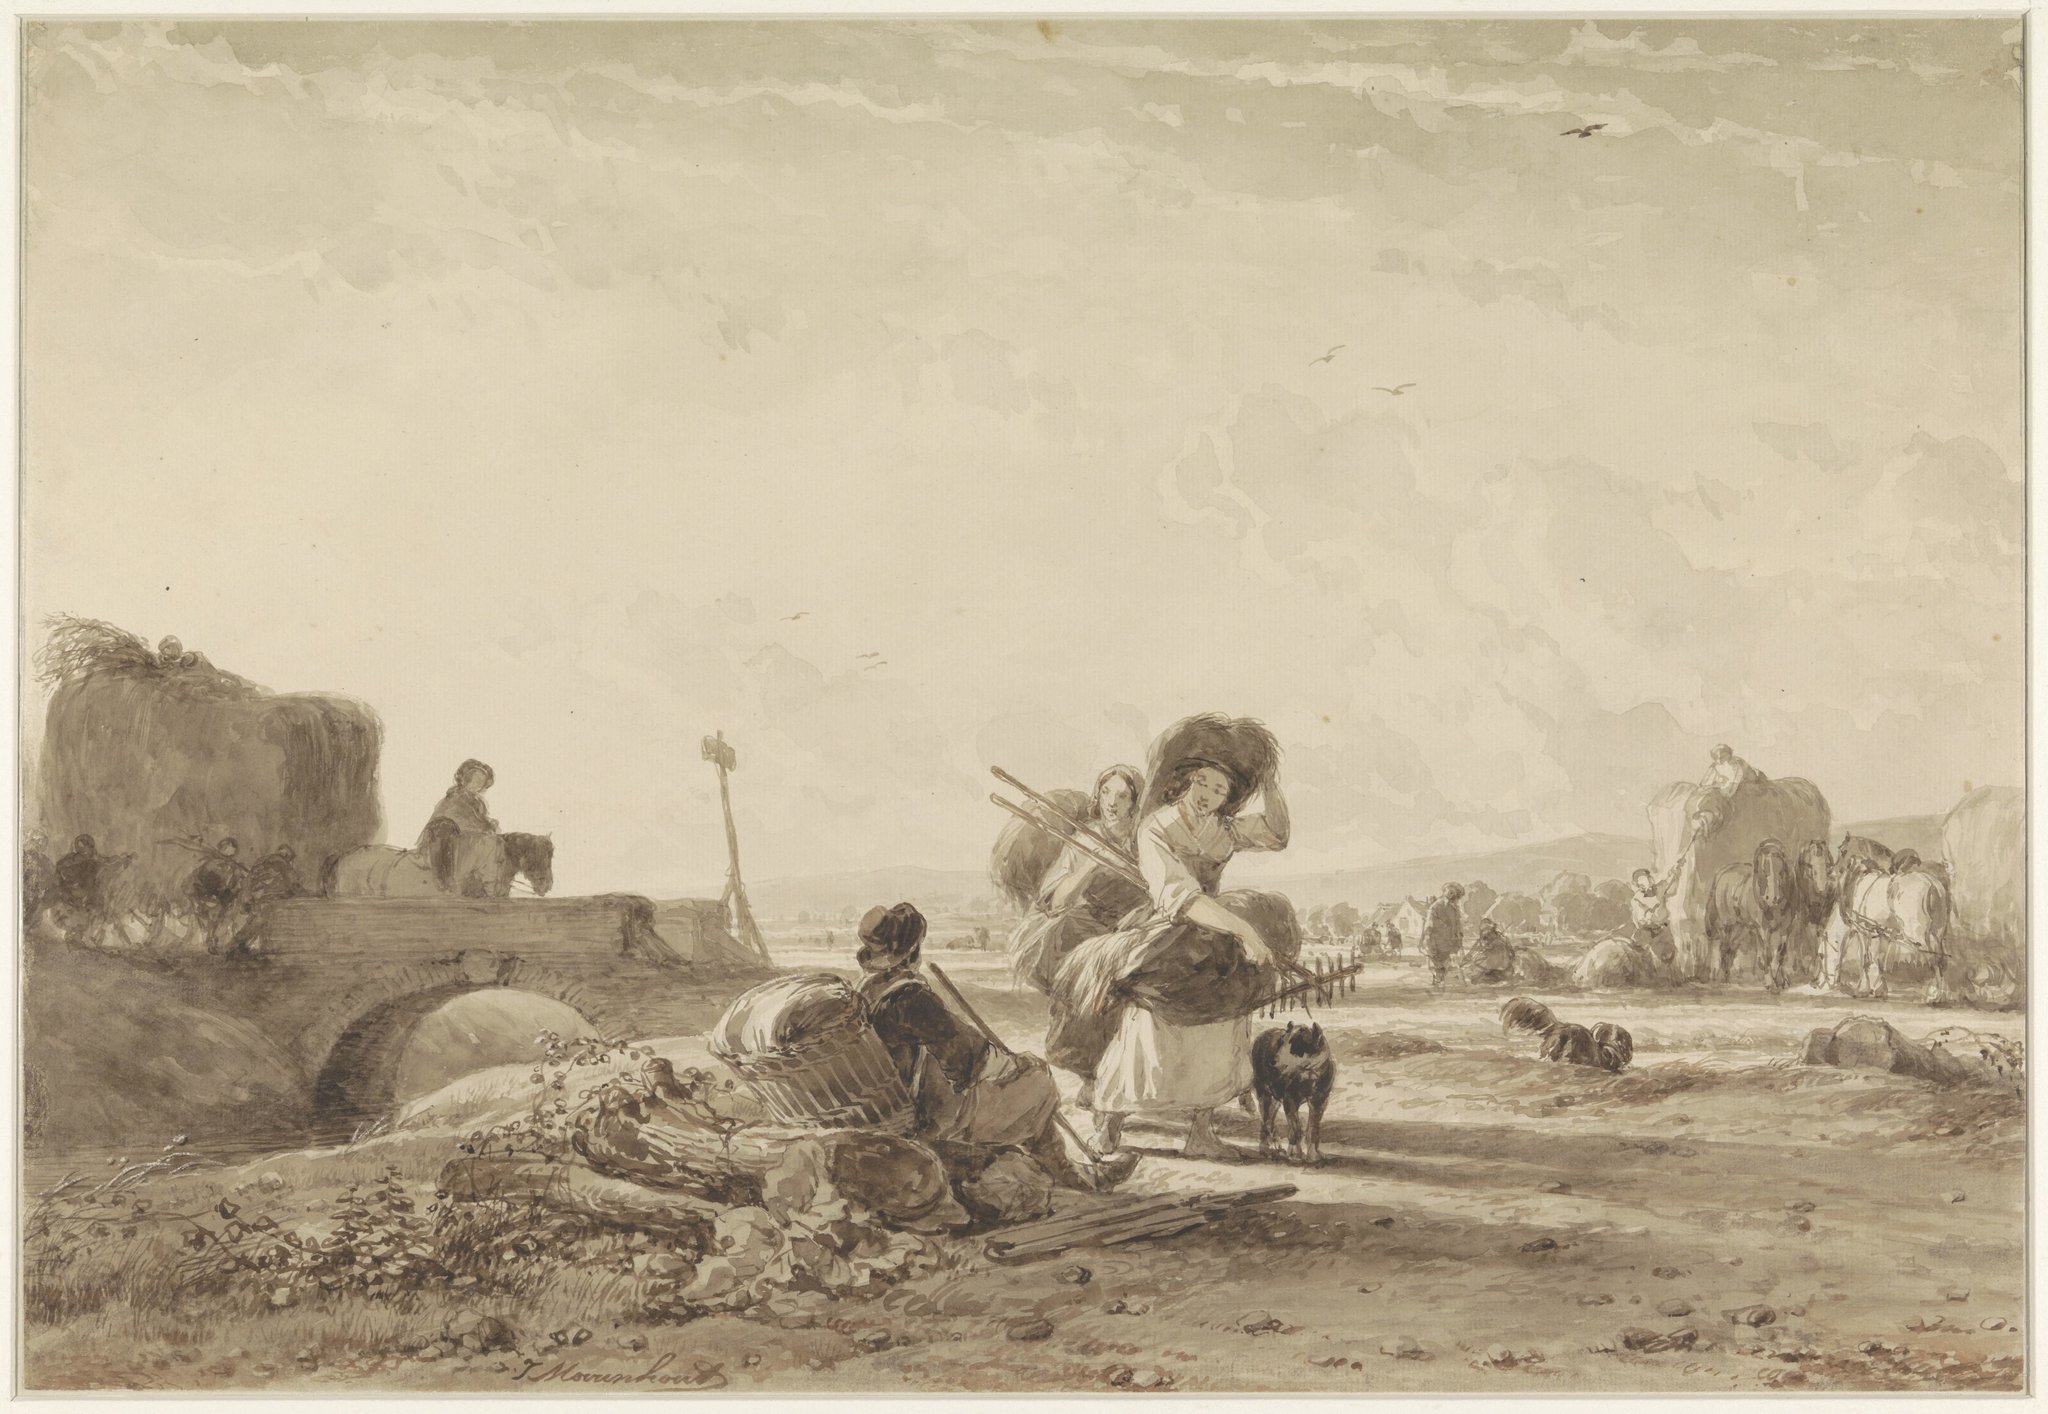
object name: drawing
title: De hooioogst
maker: joseph moerenhout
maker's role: draughtsman, painter, print maker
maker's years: 1801-1874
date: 1811-1874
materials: paper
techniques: brush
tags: agricultural products and by-products: hay, piling up ~ harvest